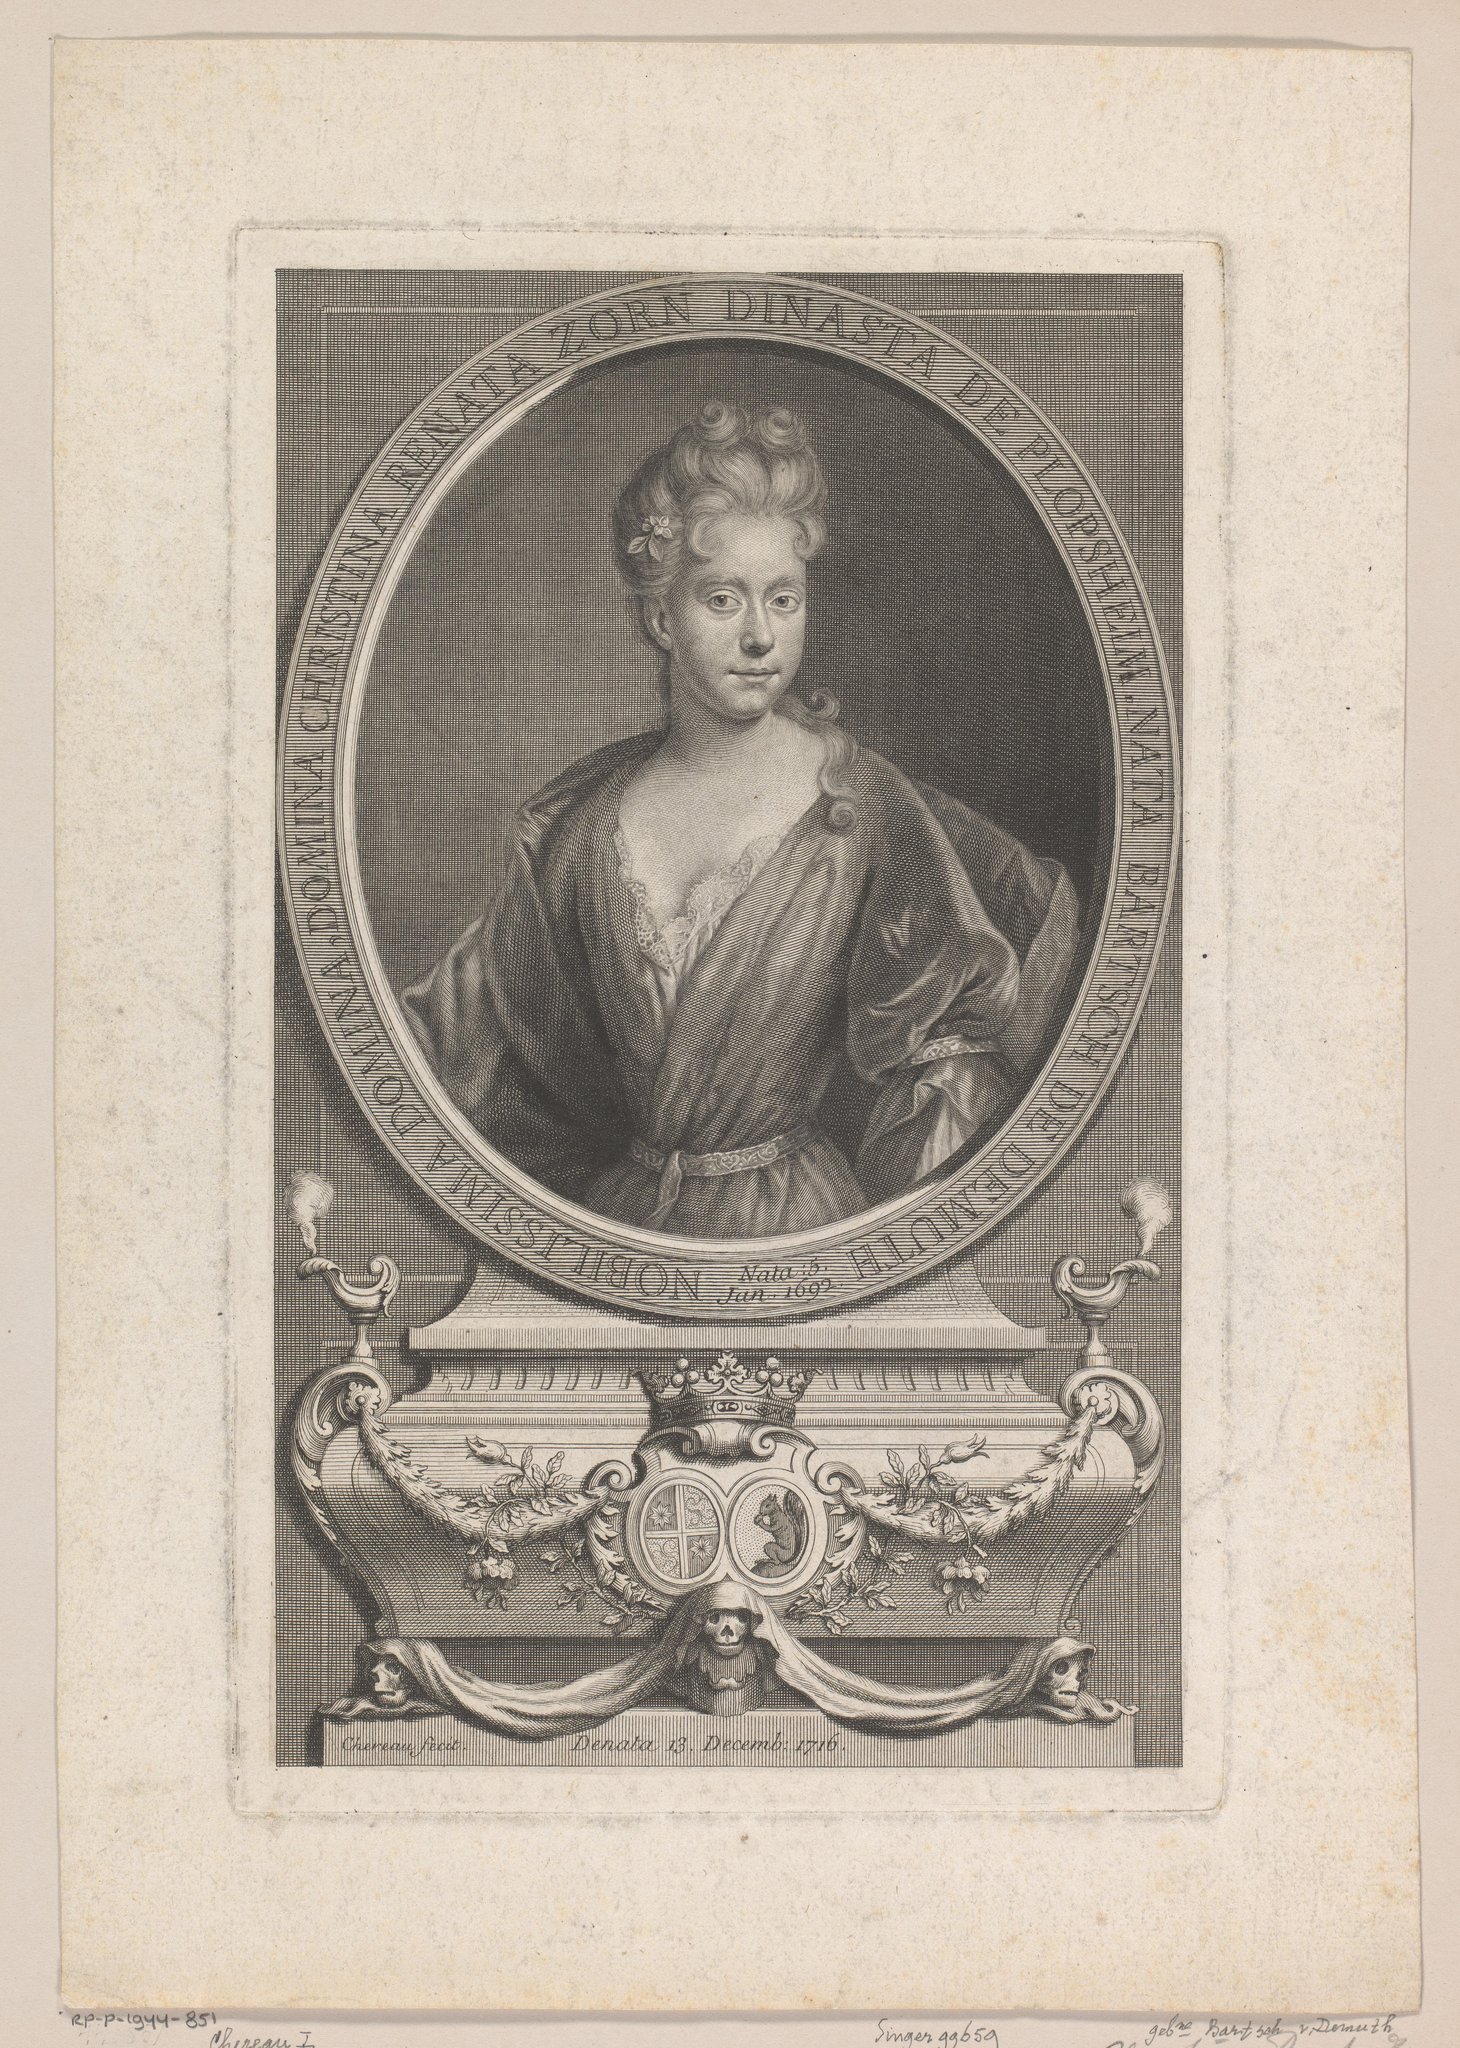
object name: print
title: Portret van Christina Renata Zorn von Plopsheim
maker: françois chéreau (i)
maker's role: print maker, publisher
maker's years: 1680-1729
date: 1716-1729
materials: paper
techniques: engraving, etching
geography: paris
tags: historical persons - bb - woman, nobility and patriciate; chivalry, knighthood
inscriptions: collector's mark: Lugt 2228, collector's mark: Lugt 9